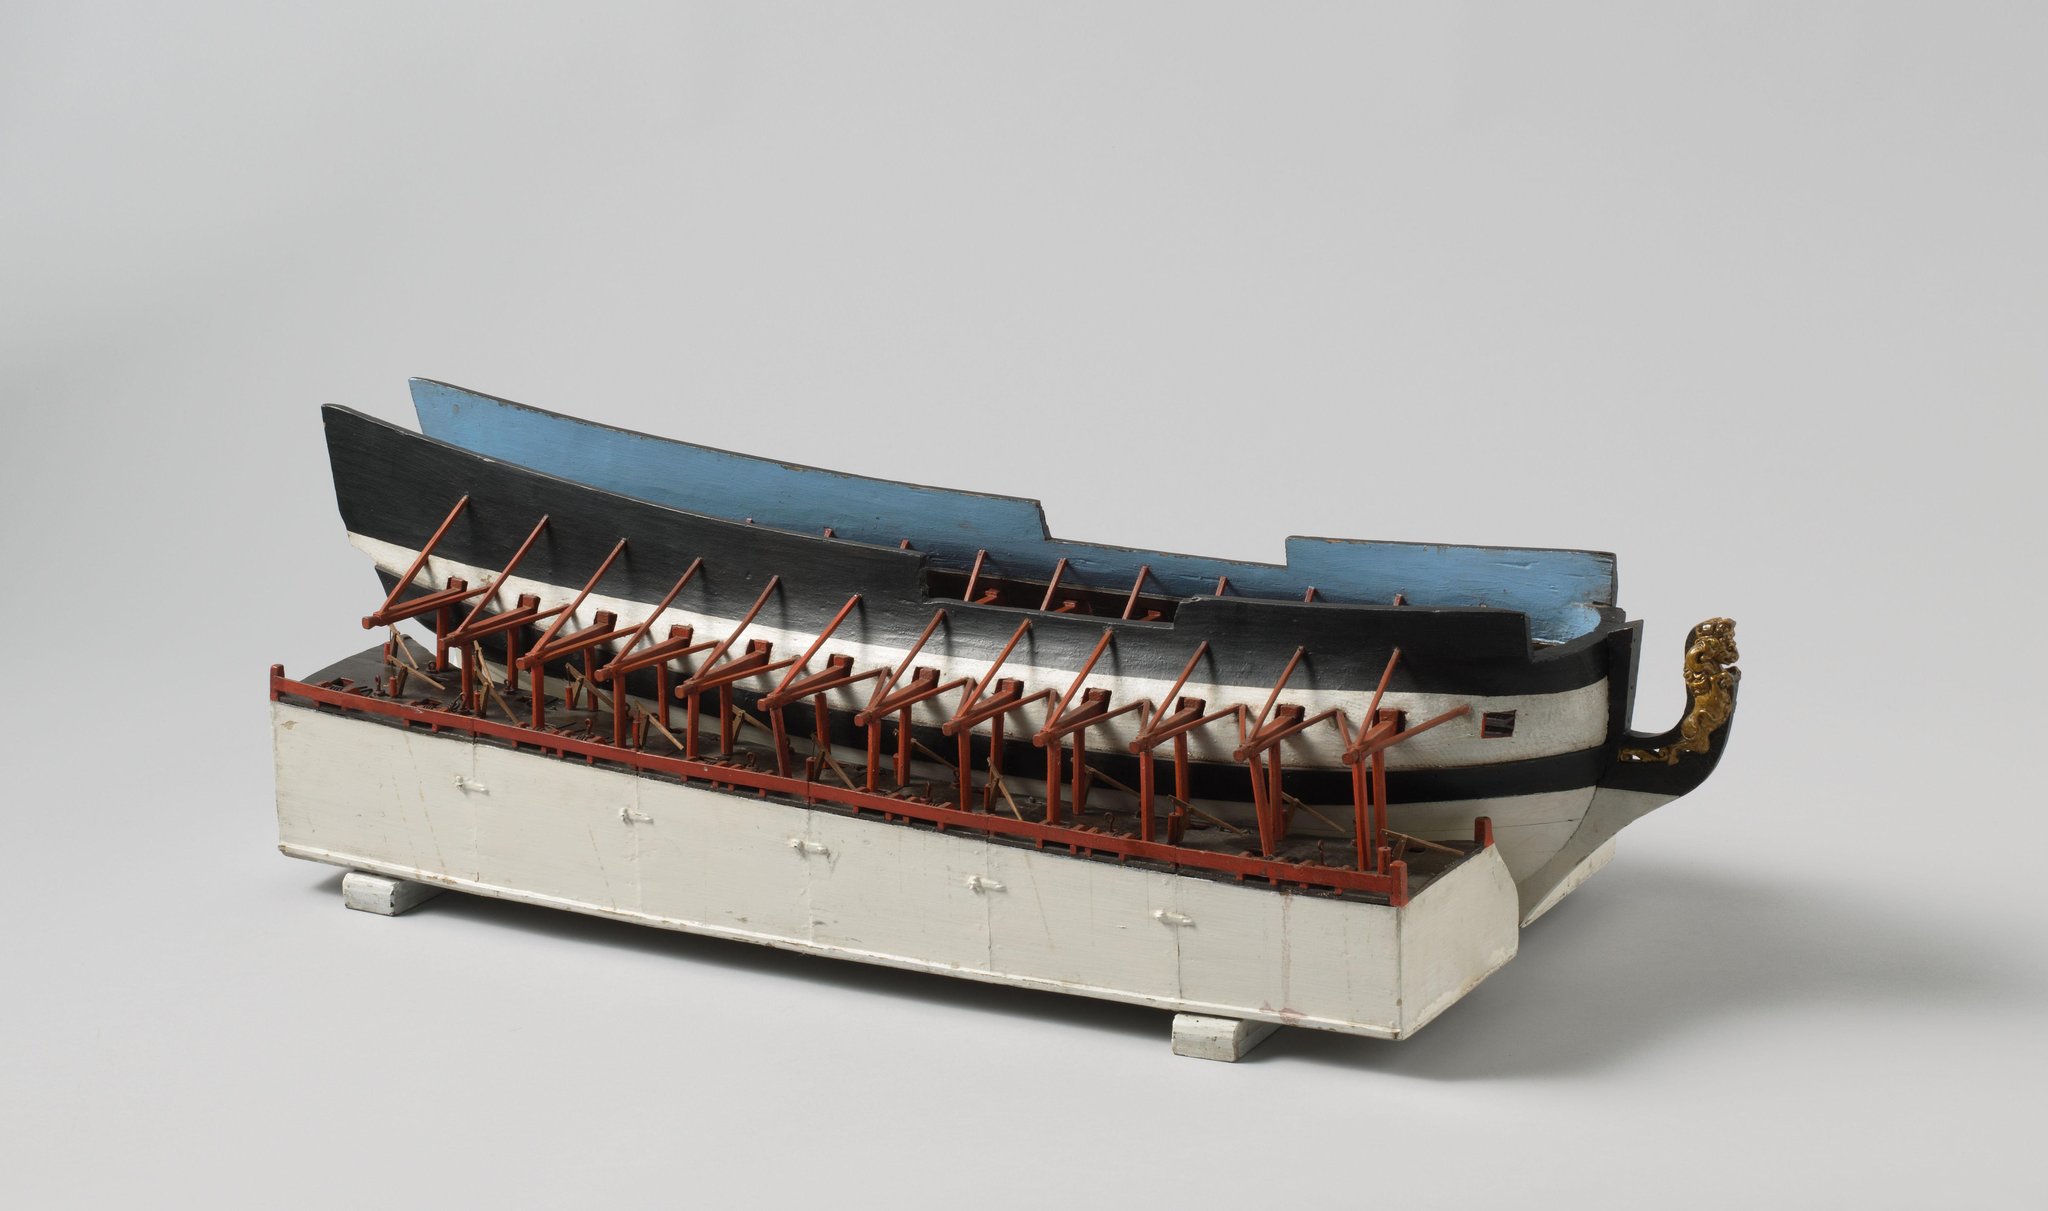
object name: demonstration model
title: Model of Composite Ship Camels Bearing a Ship under Construction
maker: Anonymous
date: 1697-1718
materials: brass, fiber, wood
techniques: polychromy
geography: italy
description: Gepolychromeerd model van een schip op scheepskamelen. Het scheepsmodel is een blokmodel van een schip in aanbouw, de bovenbouw is onvoltooid. Het schip heeft zes en twintig poorten op een dek, een gekroonde leeuw als schegbeeld, een gewrongen spiegel en hol wulf, hek en zijgalerijen zijn niet voltooid. Het schip is in de kamelen opgehangen door middel van korte balken door de geschutpoorten. De kameel aan stuurboord is samengesteld uit zes aaneengeschakelde stukken. Ieder stuk heeft een waterdicht schot in de lengte, twee pompen, twee spuien voor het vollopen, twee braadspillen en twee luiken, behalve het achterste stuk, dat twee extra pompen en spuien heeft. De bakboord scheepskameel is uit één stuk, maar verder identiek aan die van stuurboord.